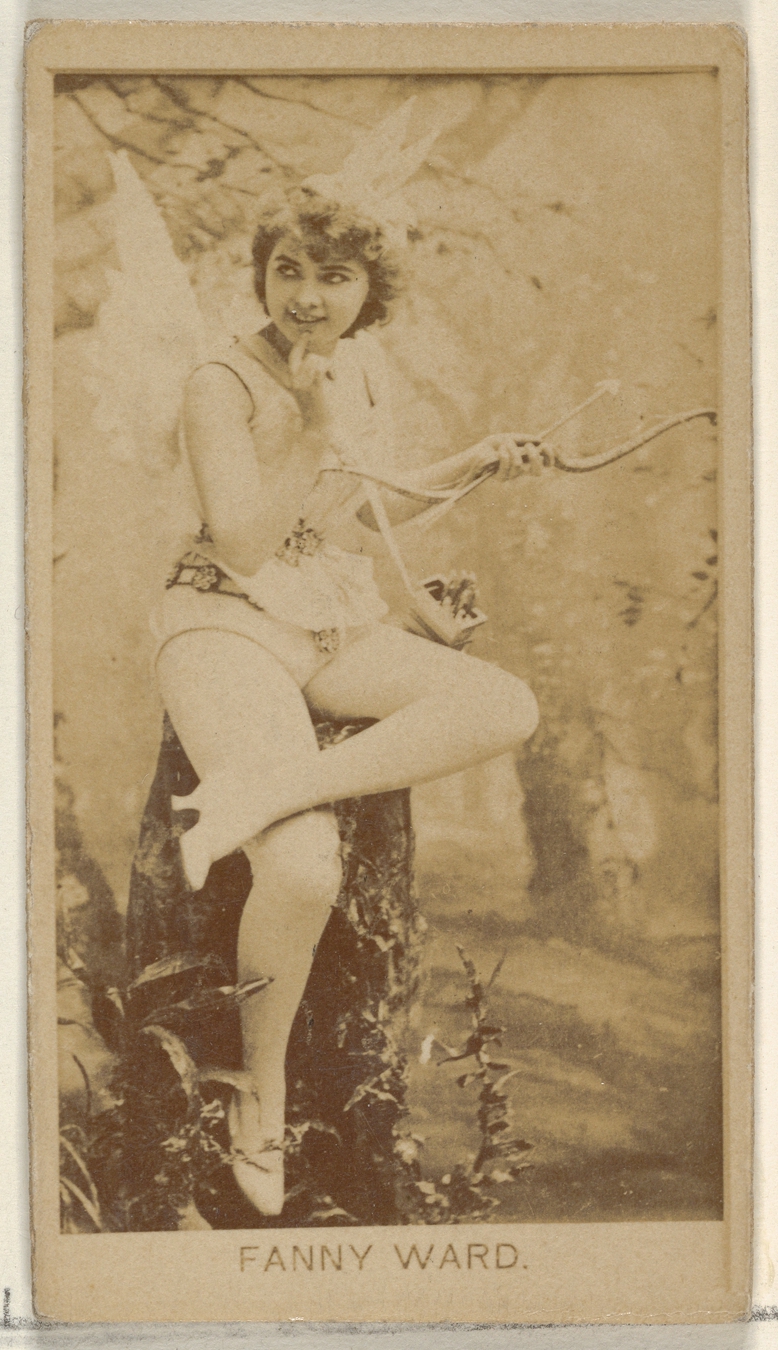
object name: photograph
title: Fanny Ward, from the Actors and Actresses series (N45, Type 8) for Virginia Brights Cigarettes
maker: allen & ginter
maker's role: publisher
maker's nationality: american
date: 1888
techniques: albumen silver print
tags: portraits,women,actresses